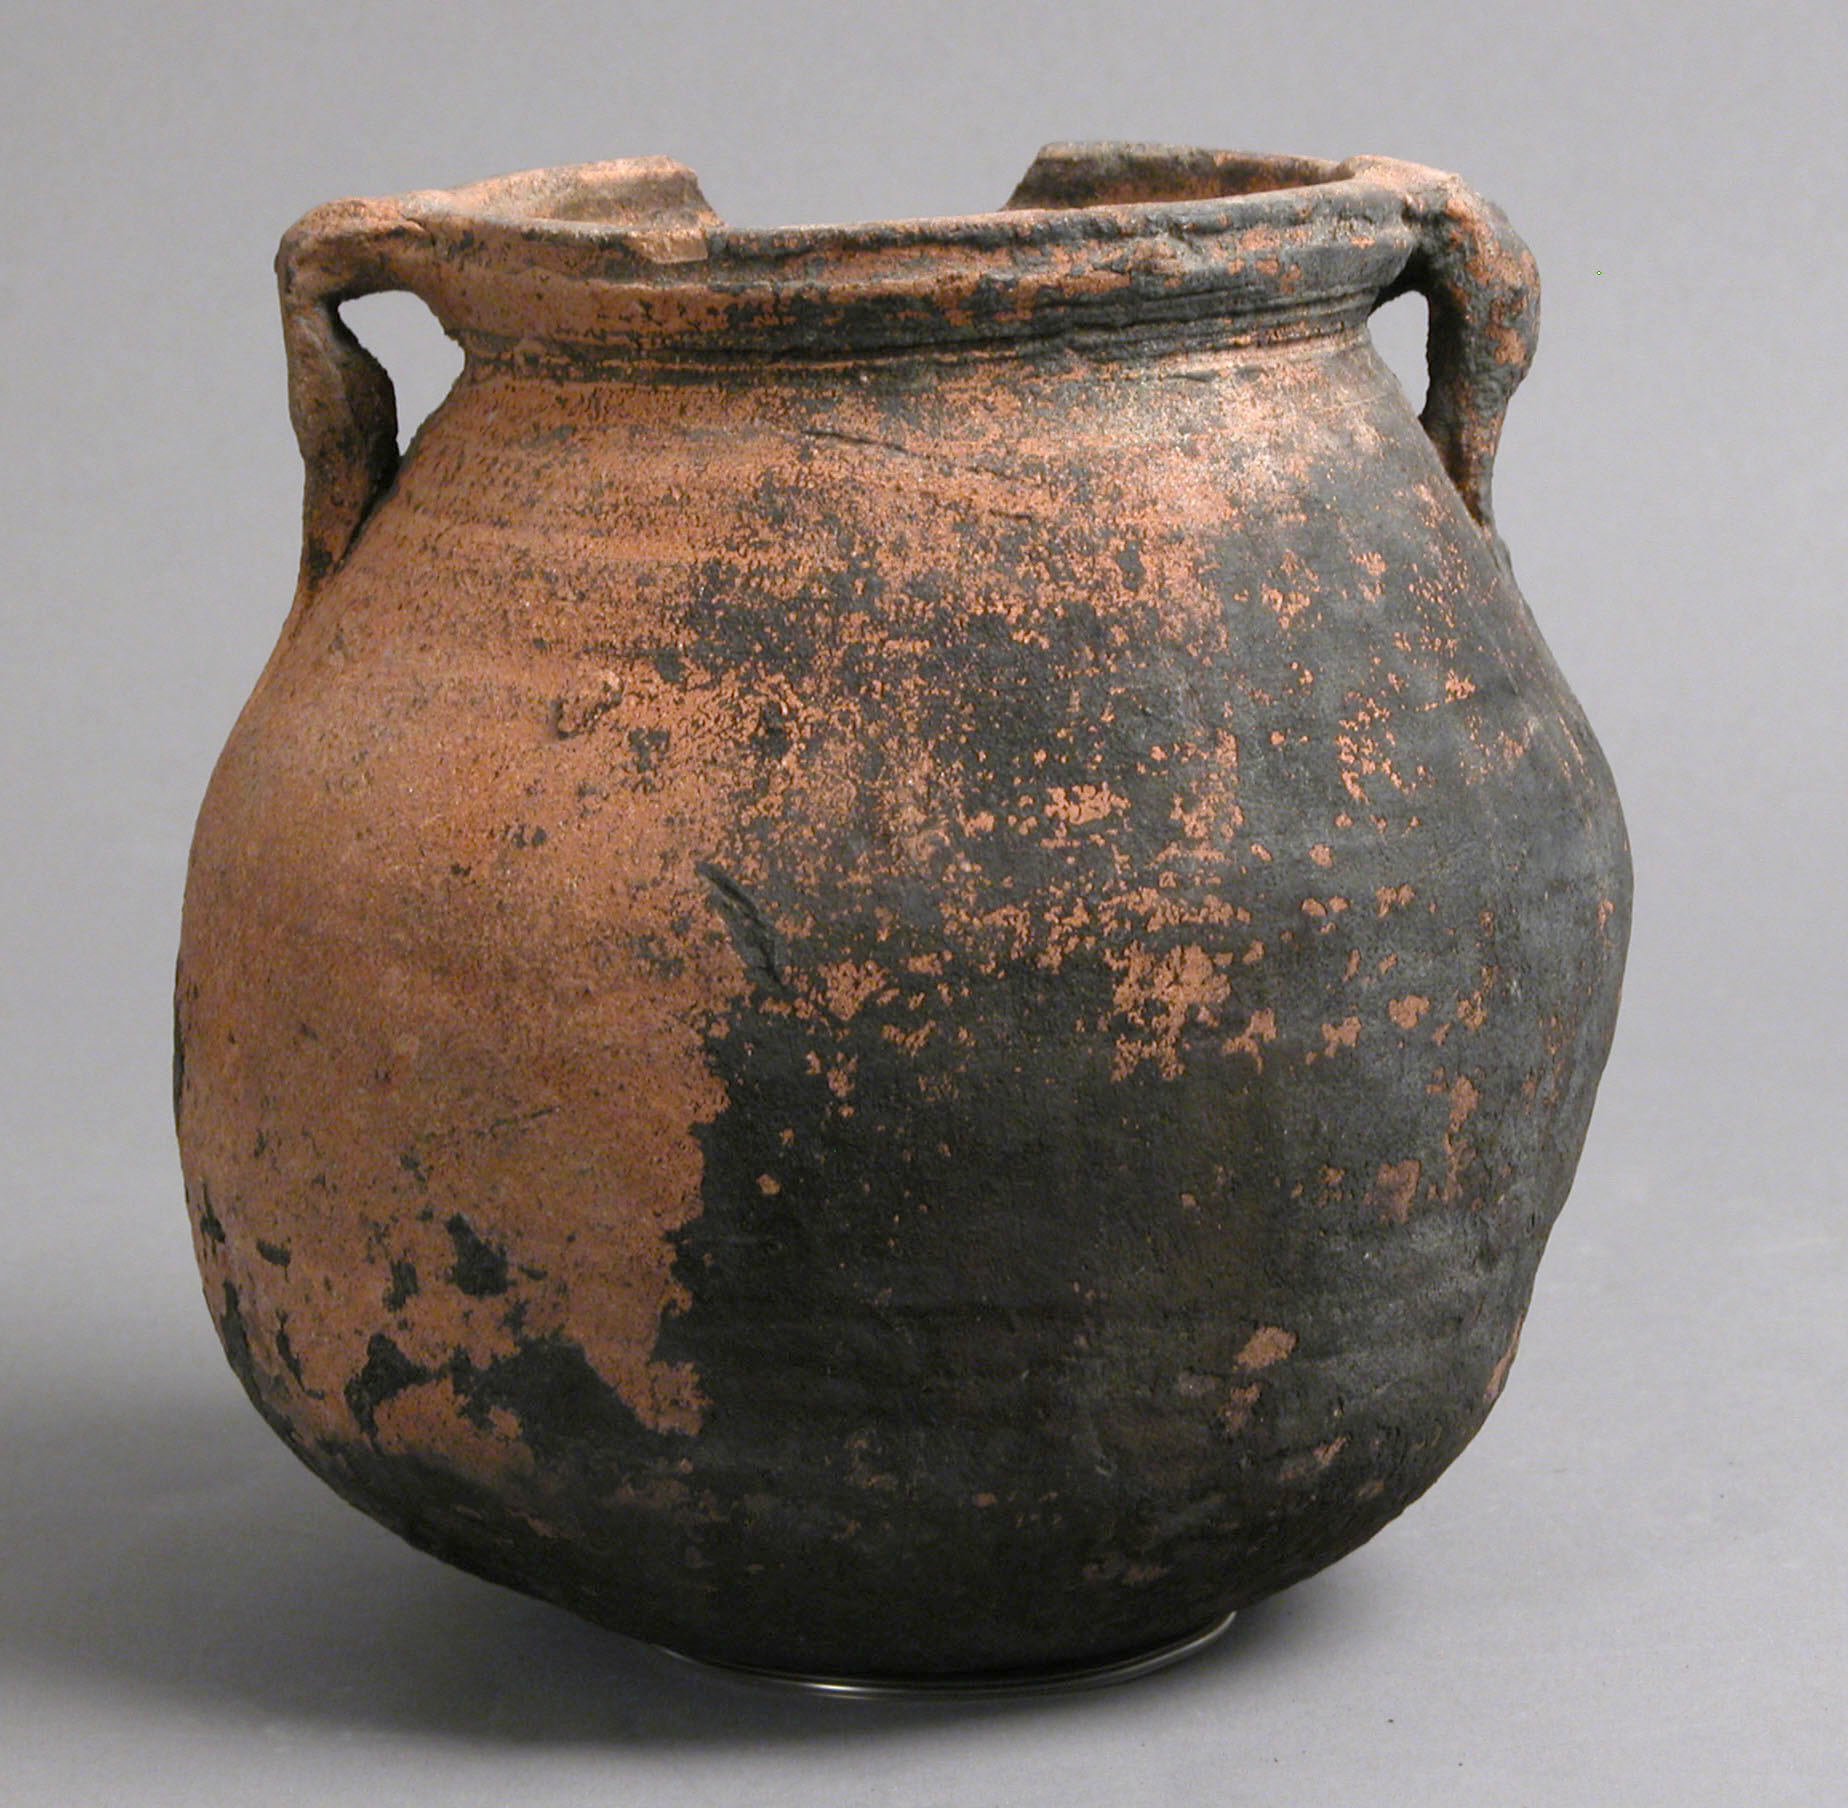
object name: pot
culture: coptic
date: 301-700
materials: earthenware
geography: egypt